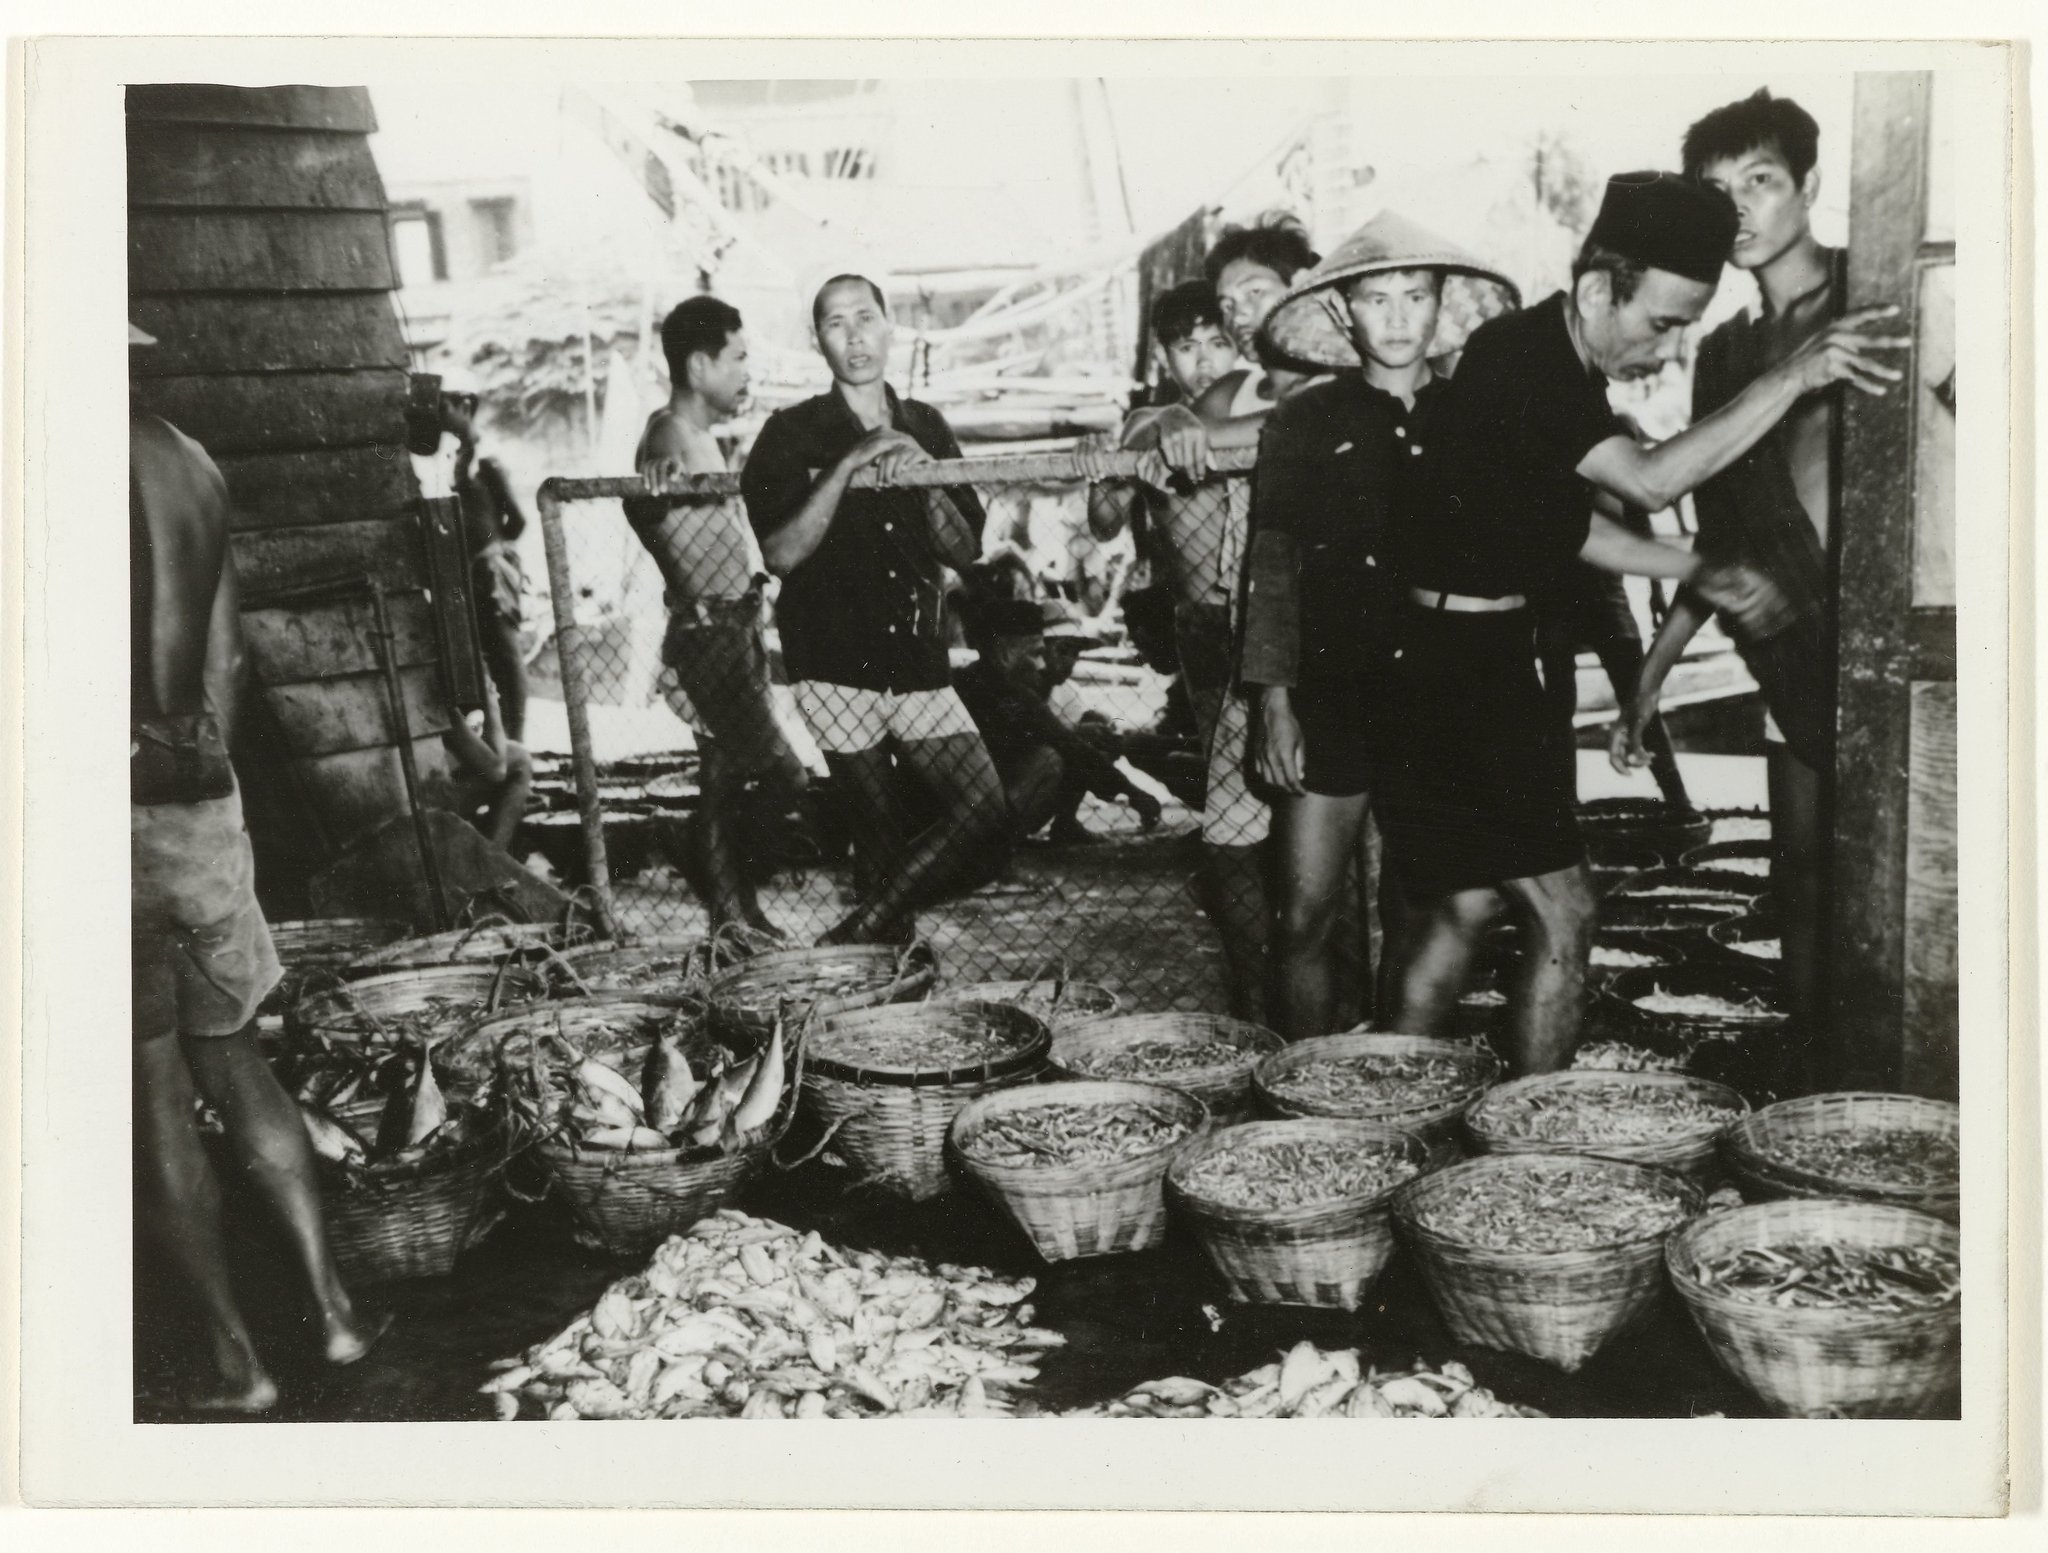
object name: photograph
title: Vismarkt te Batavia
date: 1945-1946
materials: photographic support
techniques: photography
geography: indonesia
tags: batavia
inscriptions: stamp: ‘COPYRIGHT / 'ANEFO' / ALGEMEEN NEDERLANDSCH FOTOBUREAU’, inscription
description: Vismarkt, de Pasar Ikan, te Batavia, kort na de bevrijding.